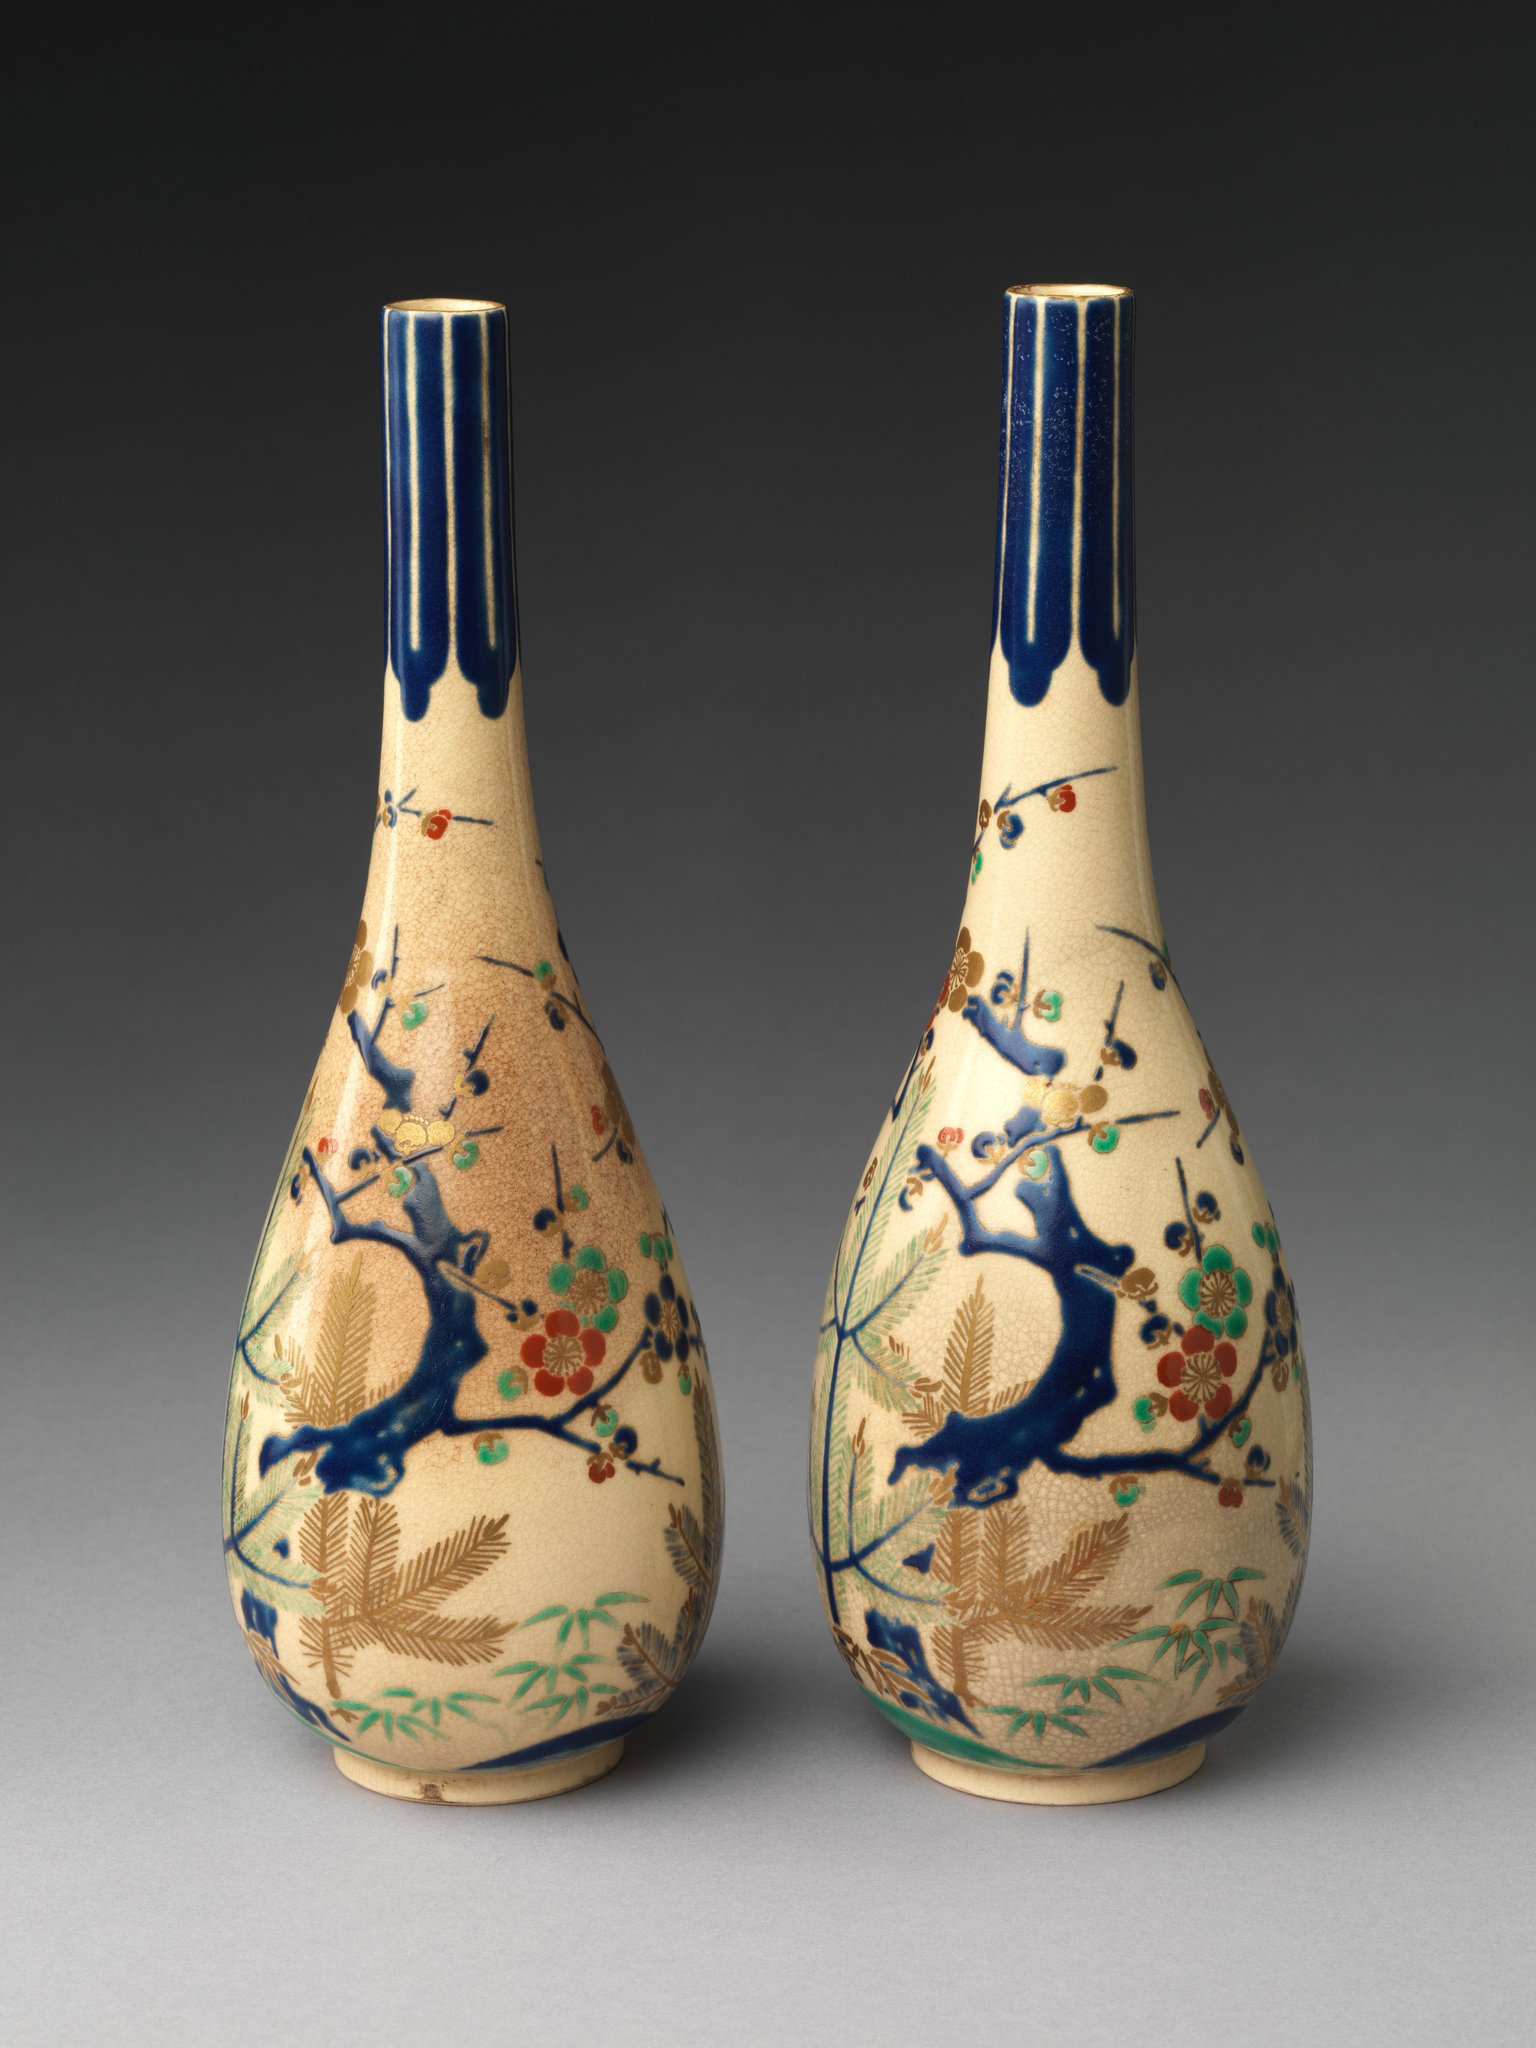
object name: bottle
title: Pair of Sake Bottles with Pine, Bamboo, and Plum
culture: japanese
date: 1701-1800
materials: enamel, gold, stoneware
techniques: overglaze, polychrome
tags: bamboo